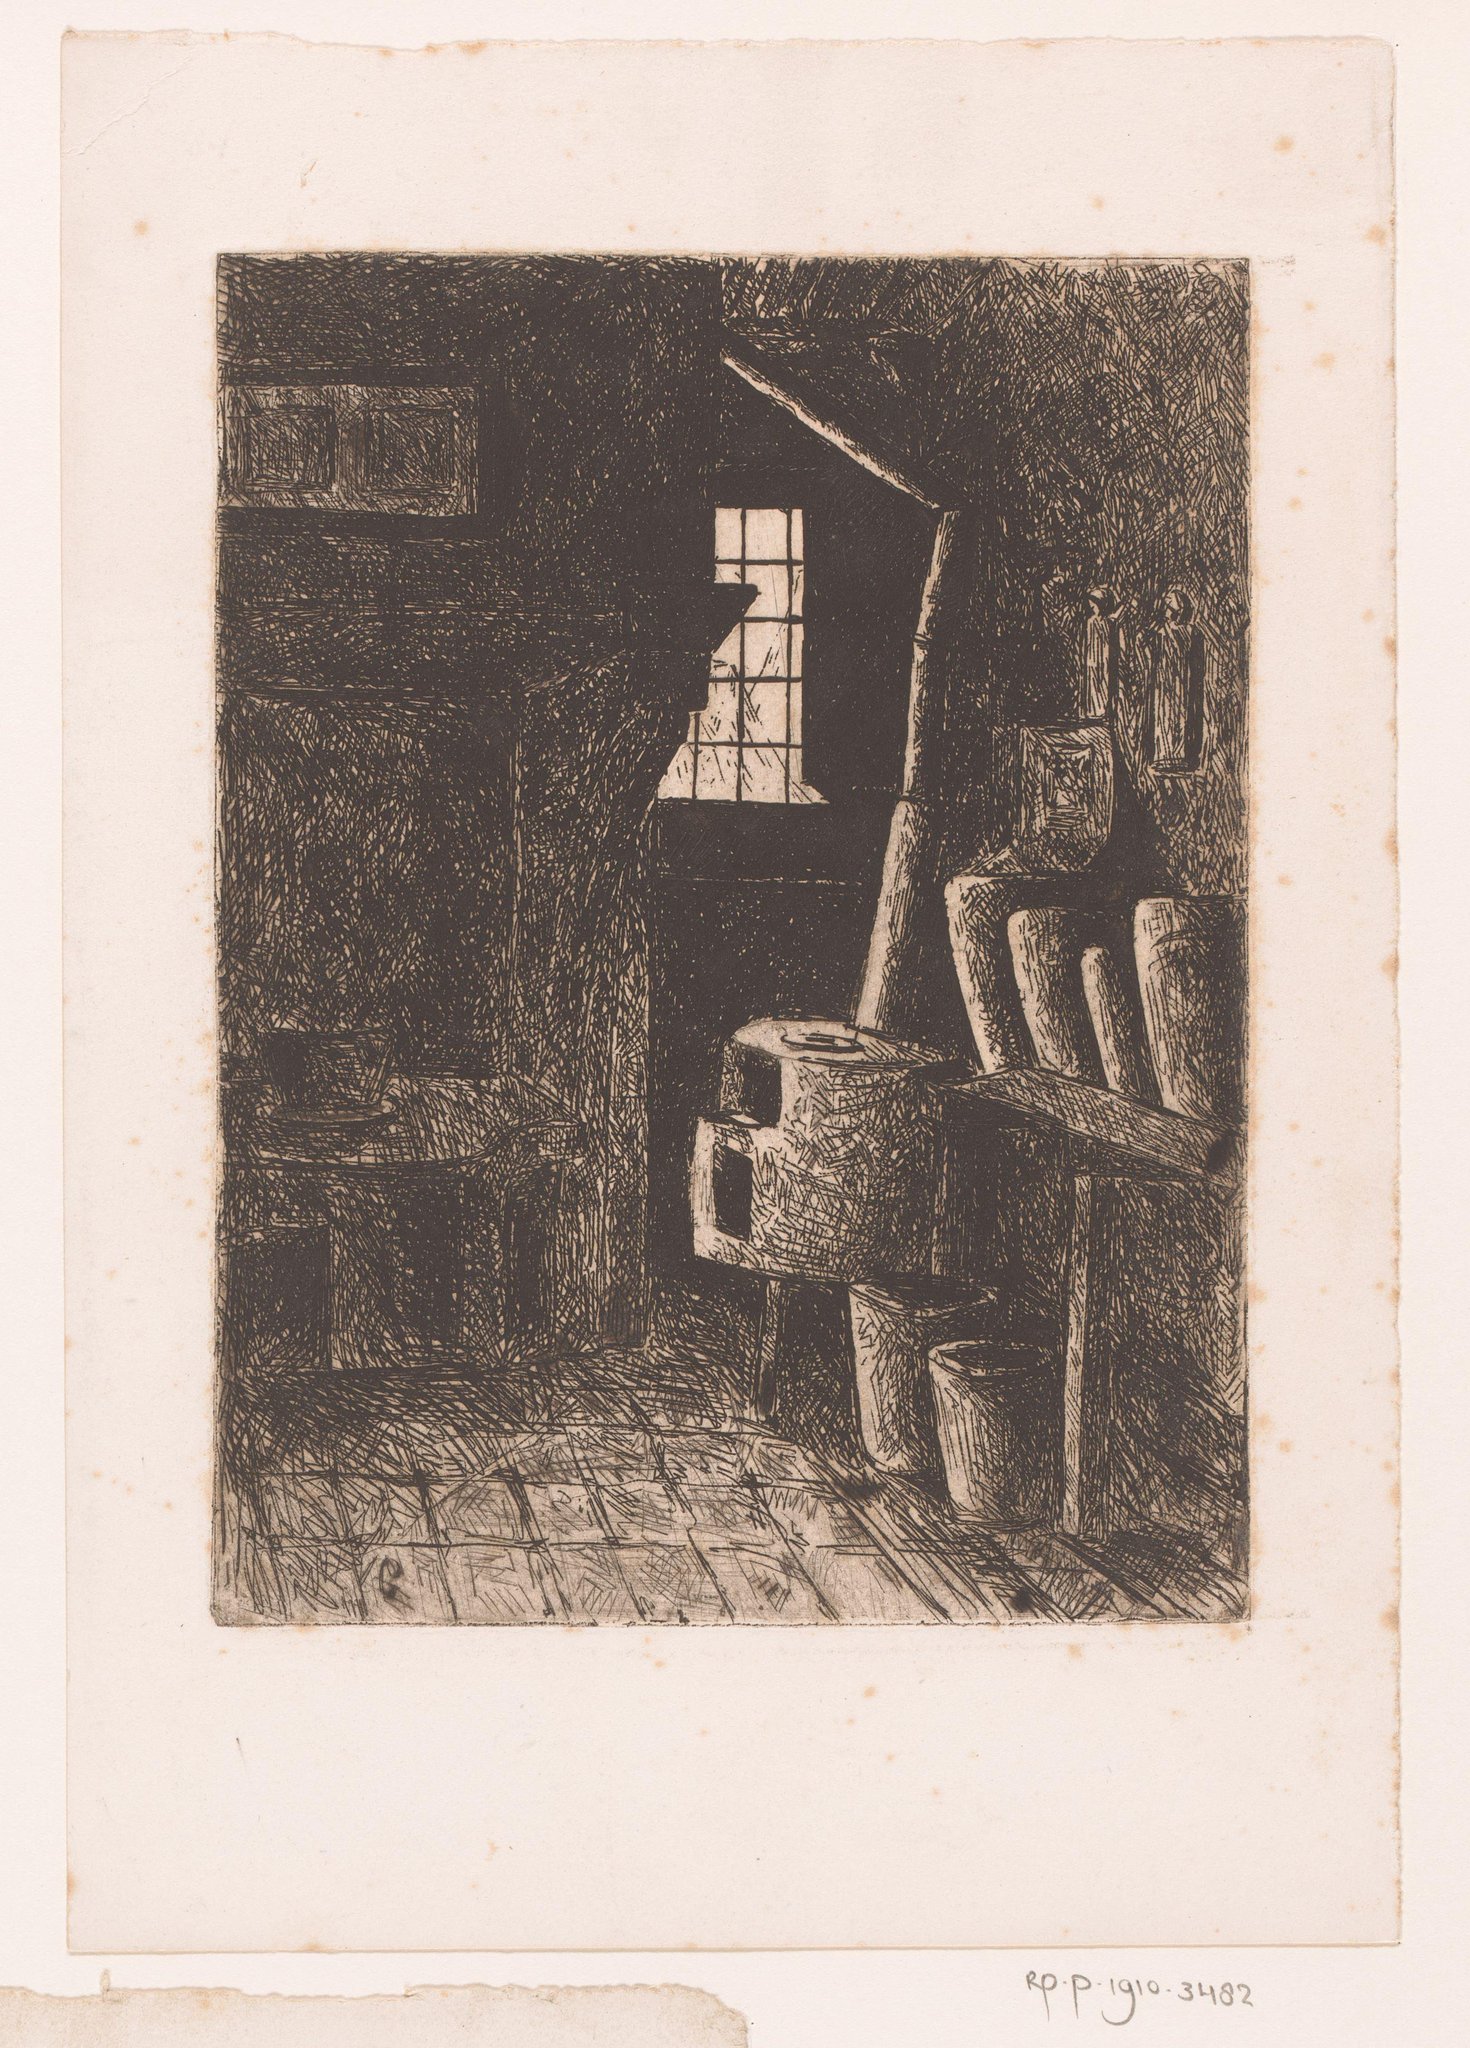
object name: print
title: Keukeninterieur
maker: fr. van groeningen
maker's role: print maker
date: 1850-1910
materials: paper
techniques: etching, intaglio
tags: kitchen-interior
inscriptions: collector's mark: Lugt 2228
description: Sterfdatum prentmaker onbekend. Derhalve is voor bepaling van de rechten van dit object de verwervingsdatum aangehouden.